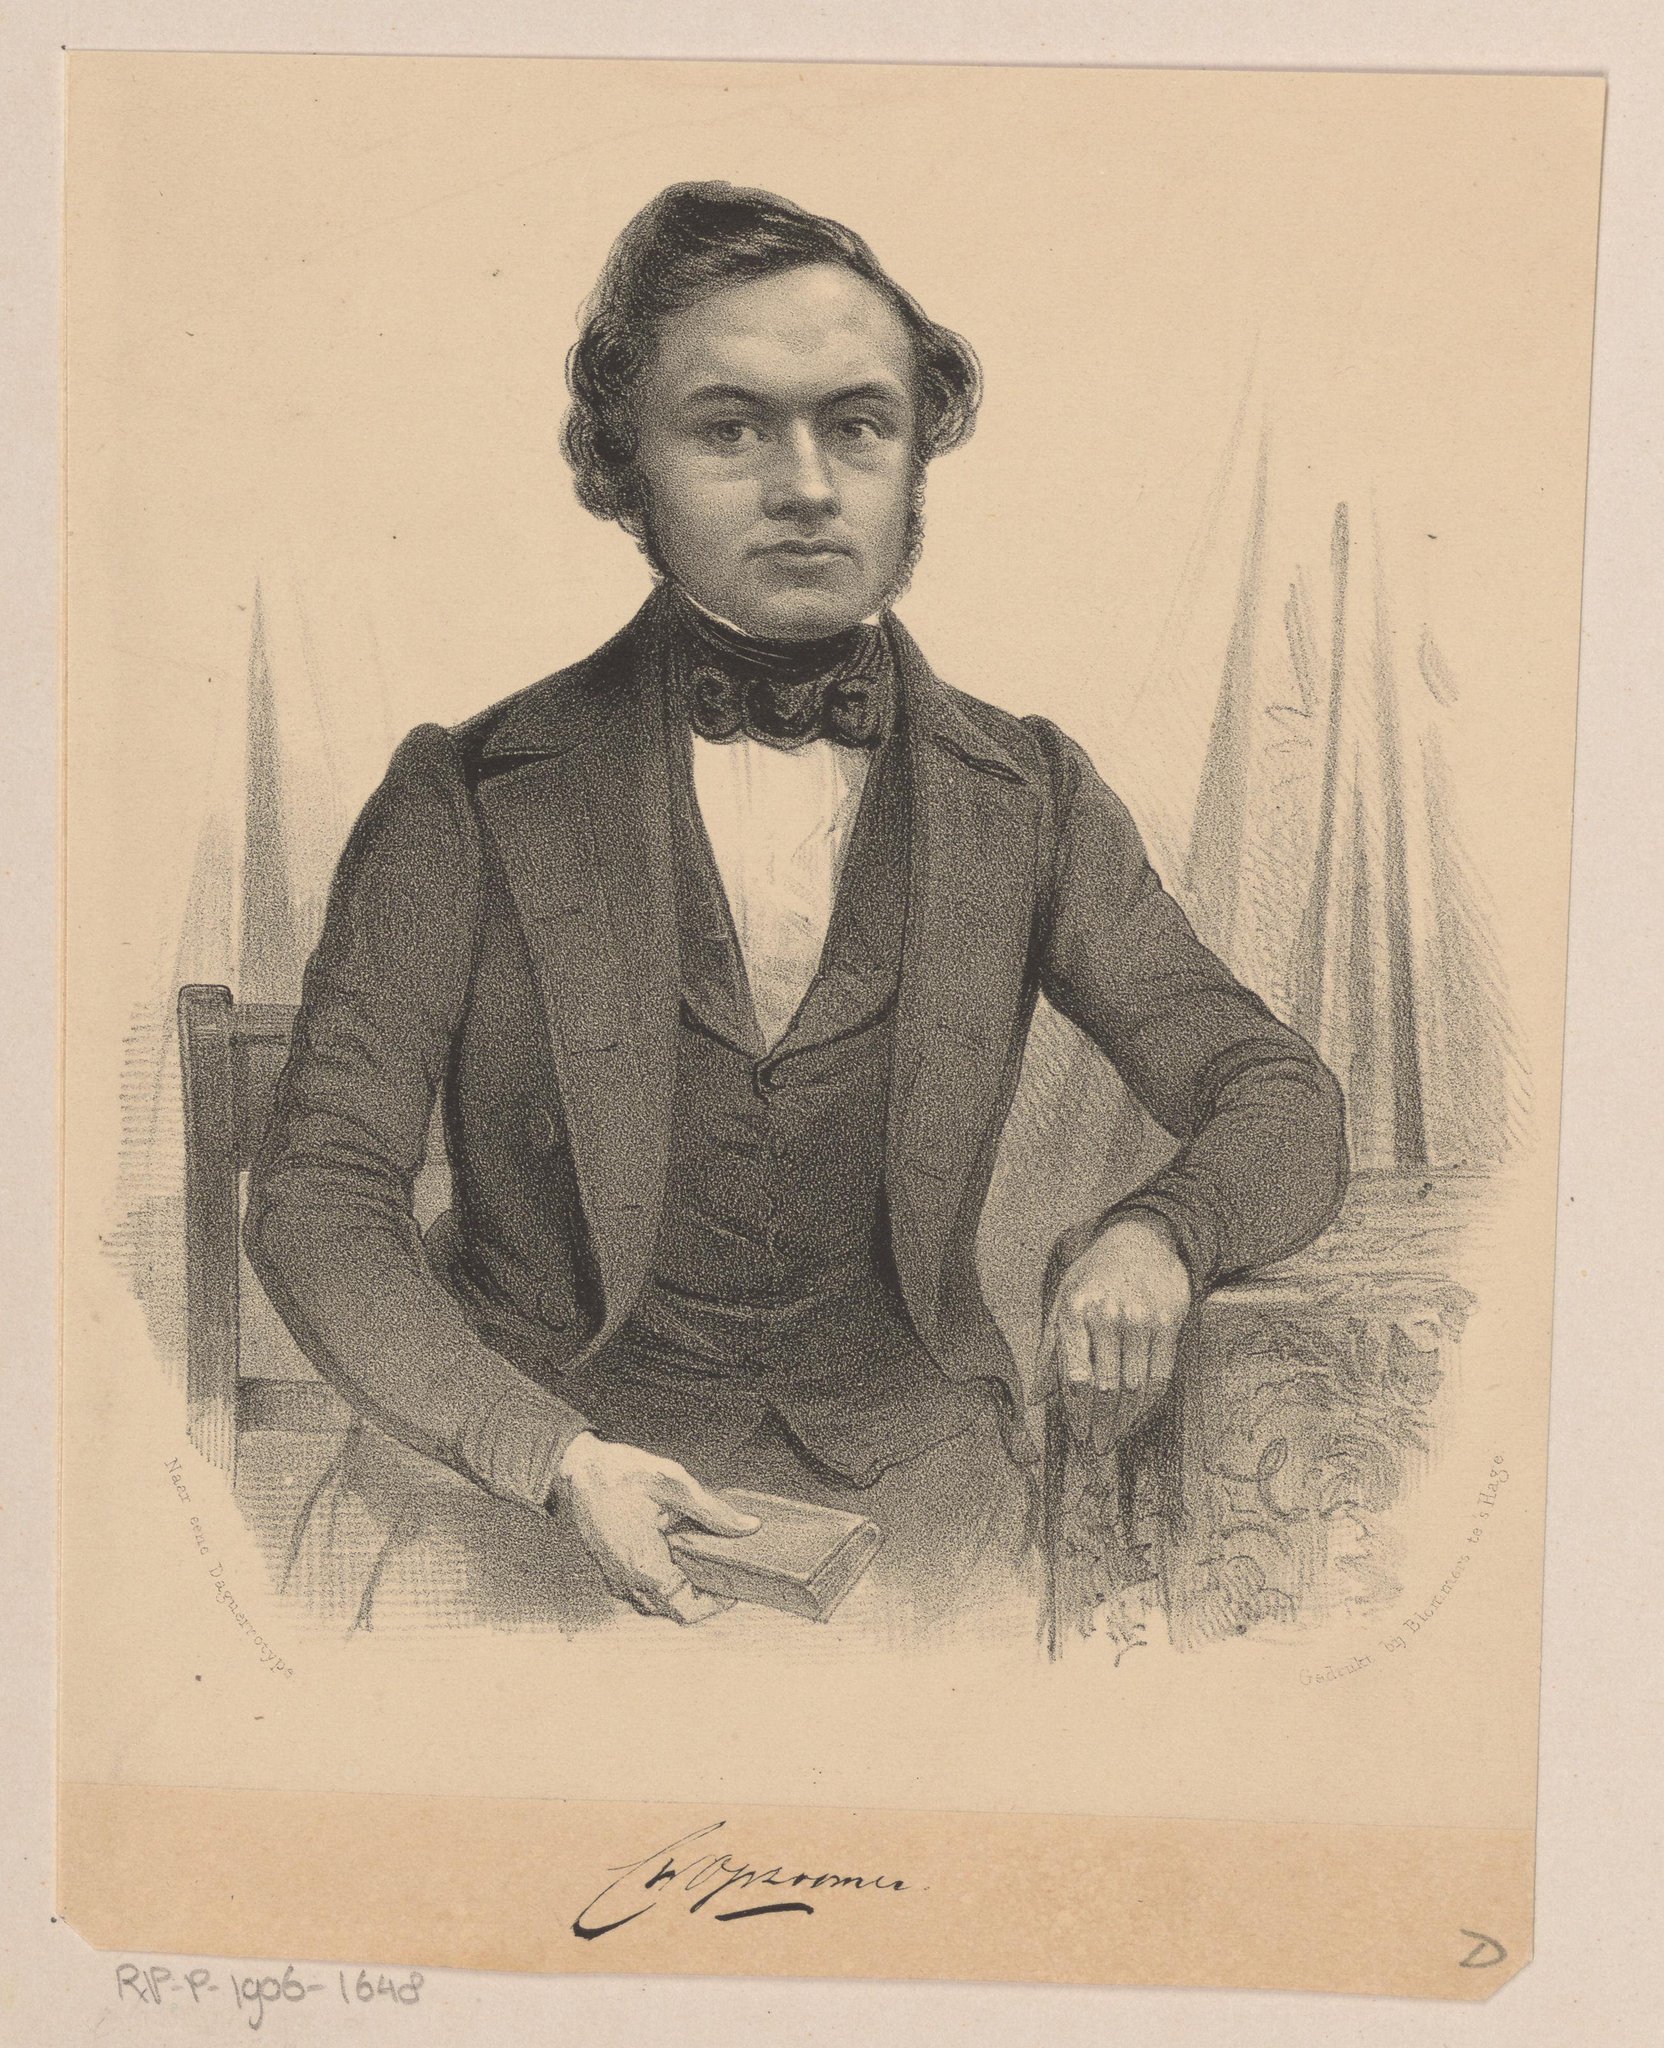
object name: print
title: Portret van Cornelis Willem Opzoomer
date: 1842-1887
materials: paper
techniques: lithograph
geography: the hague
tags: rotterdam, historical persons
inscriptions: collector's mark: Lugt 2228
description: Onder het portret een facsimile van de handtekening van de geportretteerde.